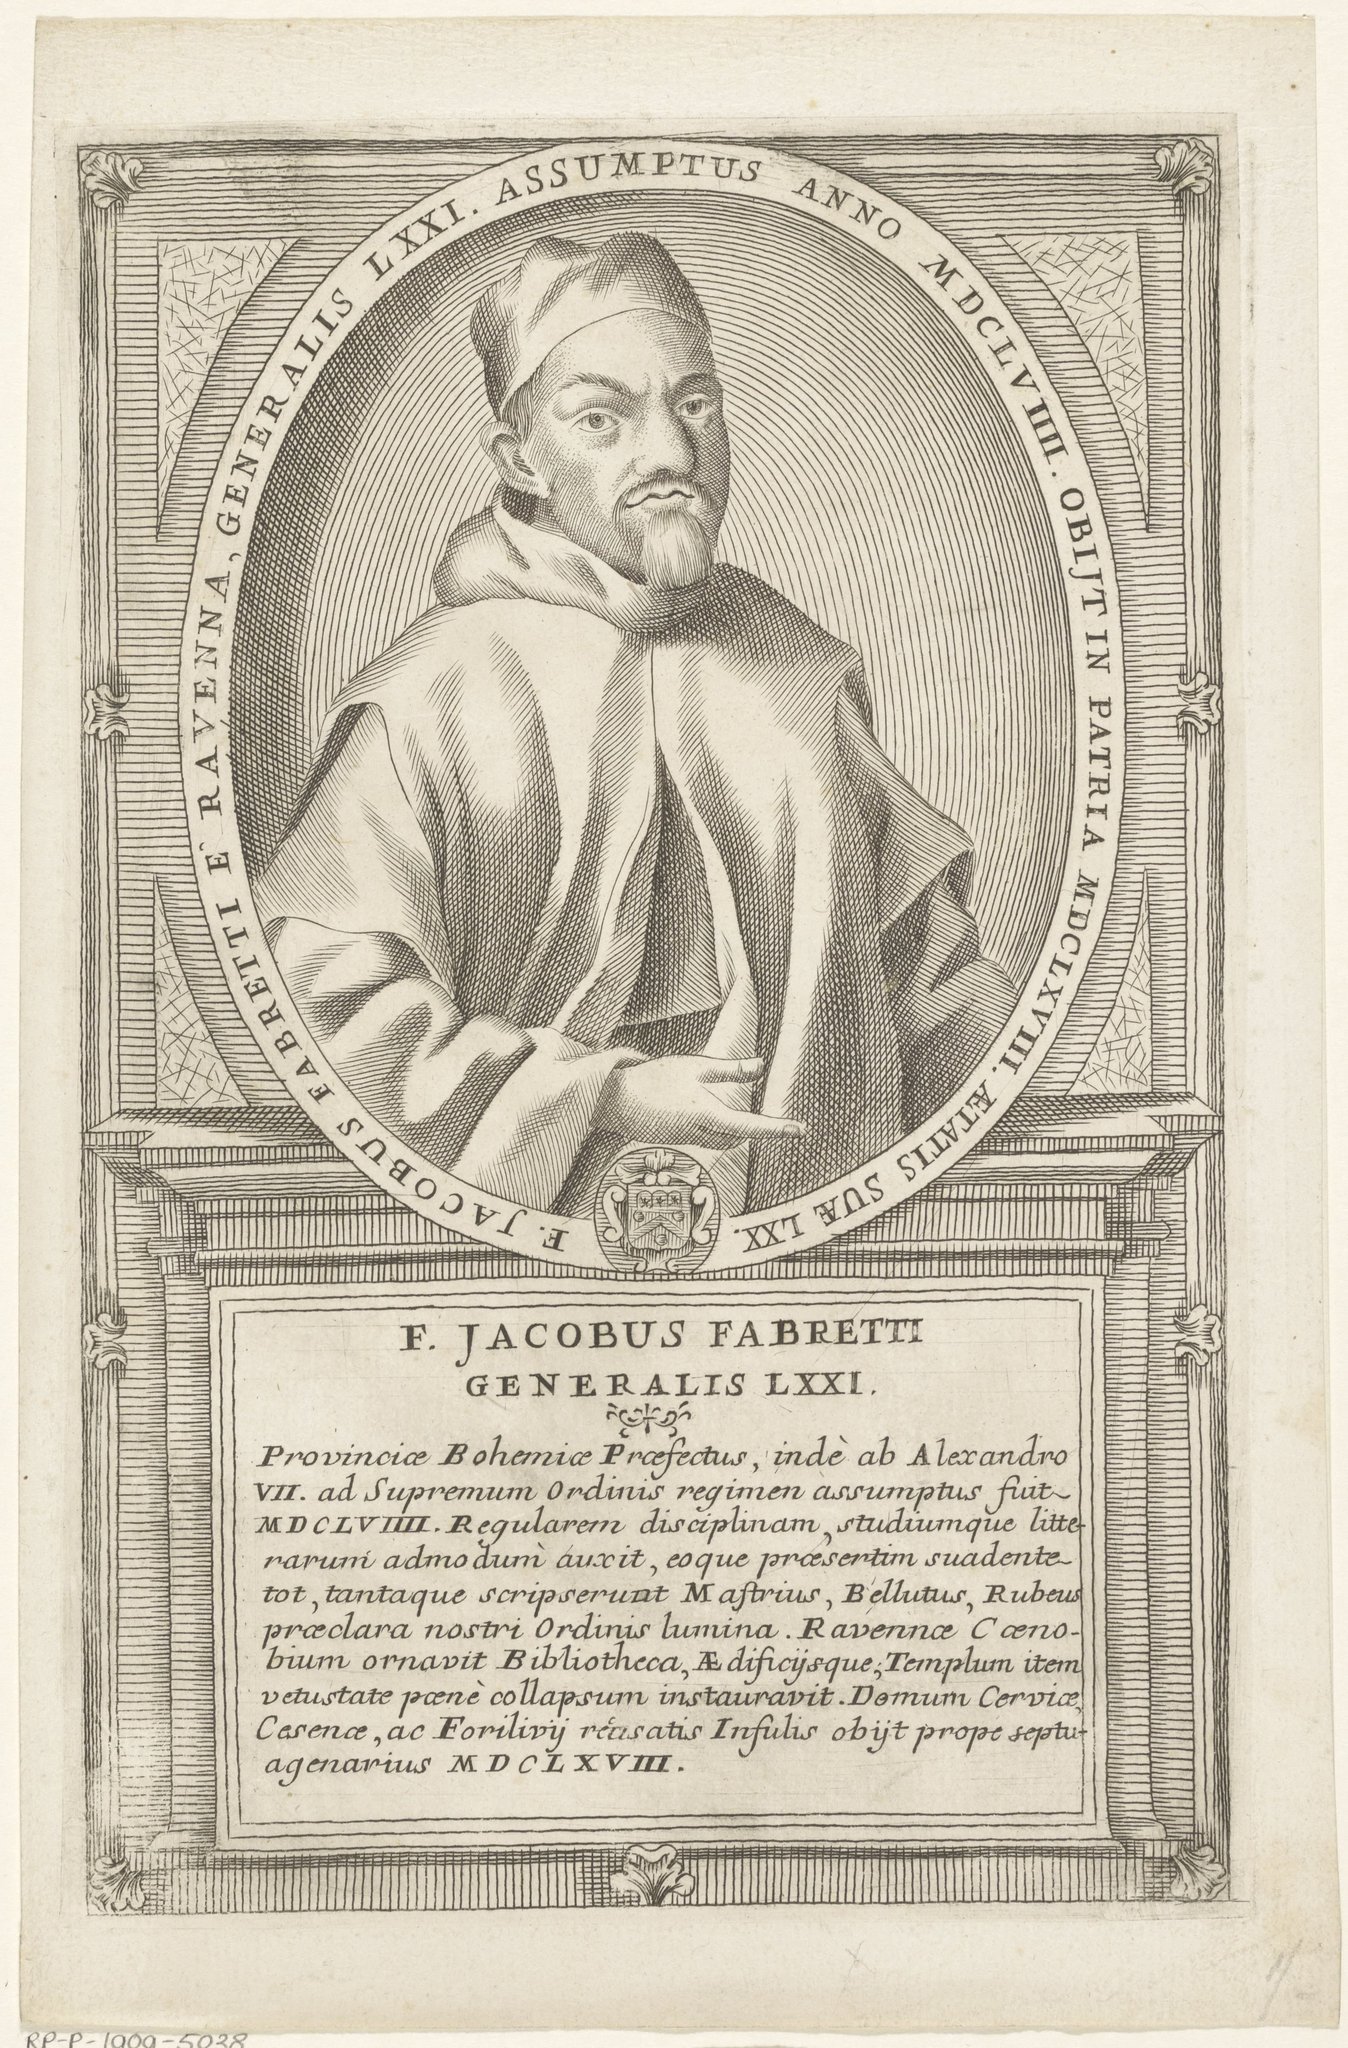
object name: print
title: Portret van Jaime Fabretti, 71ste Minister Generaal van de franciscaner orde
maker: antonio luciani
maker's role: print maker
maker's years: 1700-1738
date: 1710-1738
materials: paper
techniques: engraving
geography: italy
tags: historical persons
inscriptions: collector's mark: Lugt 2228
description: Deze prent maakt deel uit van een groep van 60 portretten.